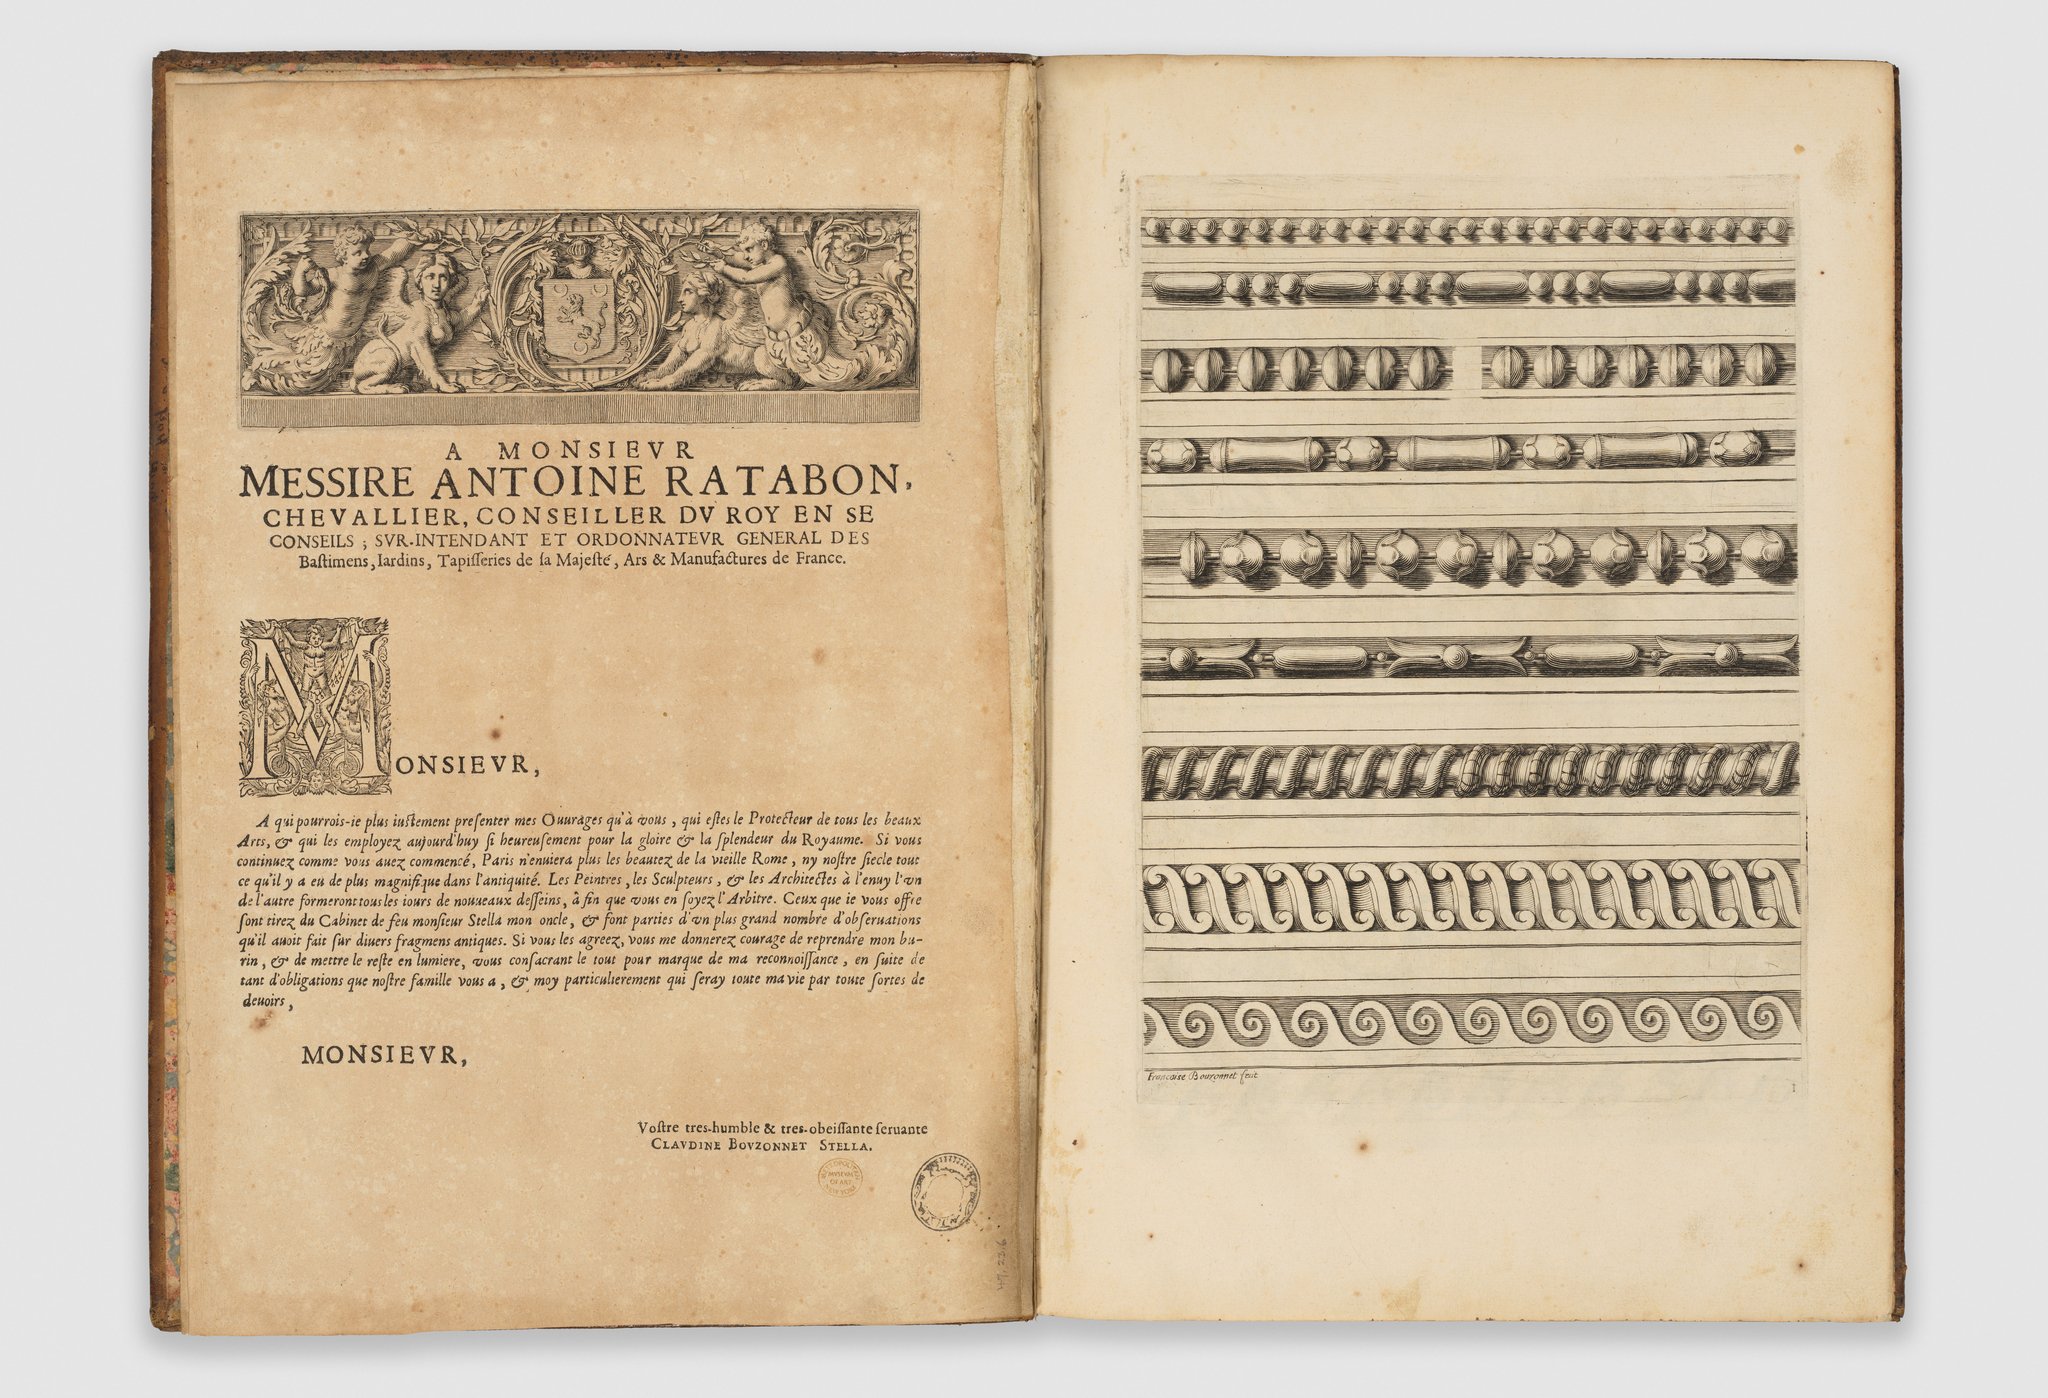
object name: book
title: Divers Ornements D'Architecture, Recueillis et Dessegnes Apres L'Antique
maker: jacques stella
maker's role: artist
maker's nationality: french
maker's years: 1596-1657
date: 1658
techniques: engraving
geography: france